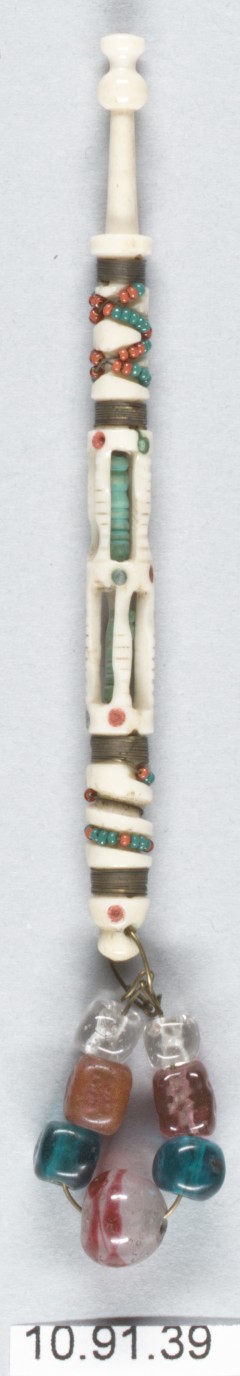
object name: bobbin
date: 1801-1900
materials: bone, metal